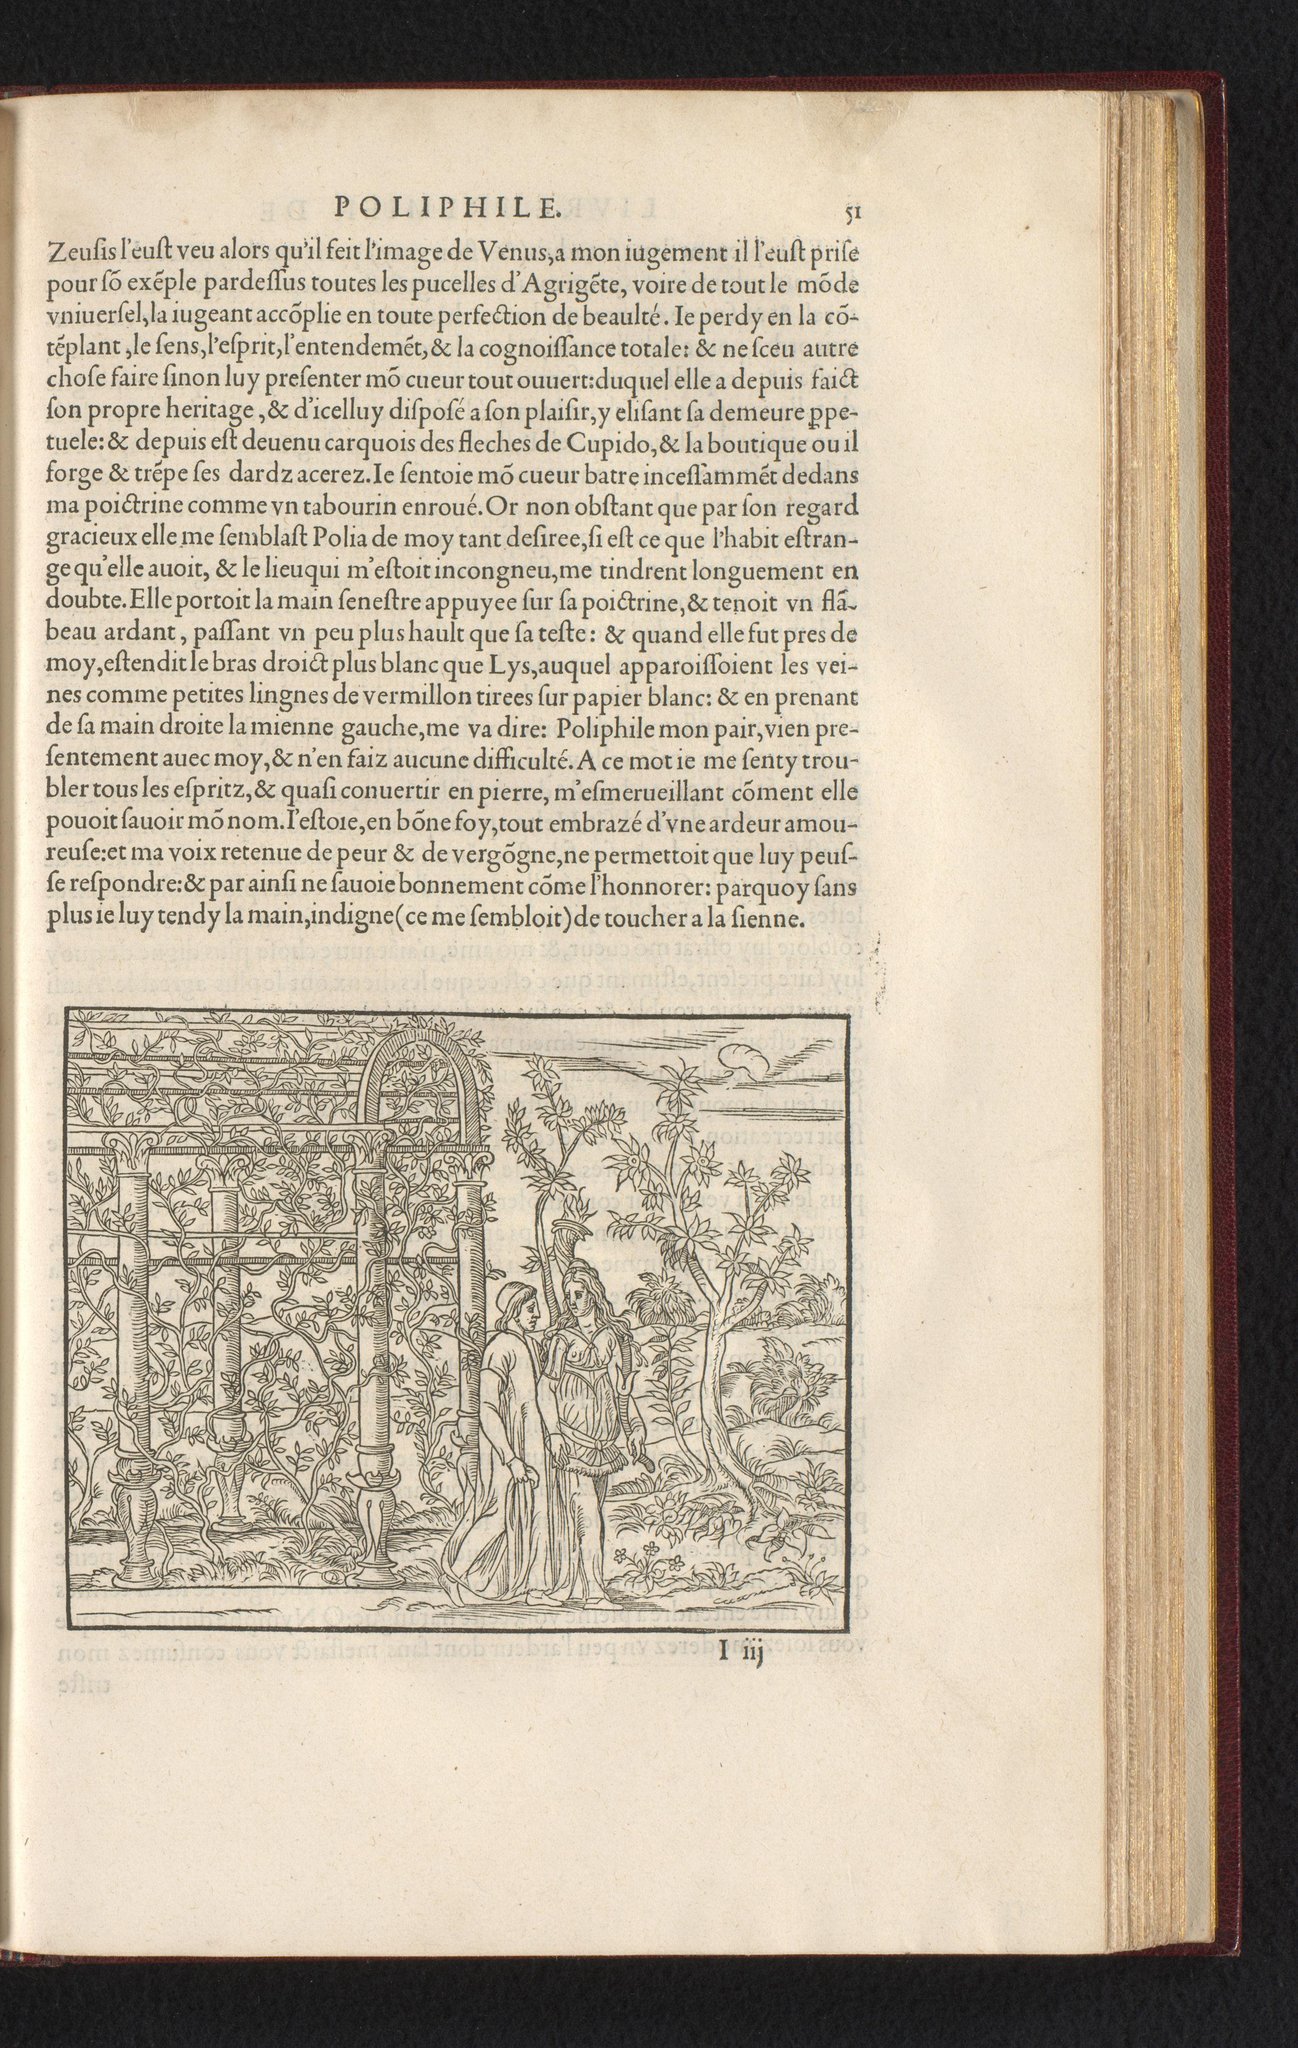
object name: page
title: Poliphilo meegevoerd door een nimf met fakkel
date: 1546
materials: paper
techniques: letterpress printing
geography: paris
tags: torch, leading someone by the hand or wrist, (scenes from) specific works of literature: colonna, hypnerotomachia poliphili, nymphs (in general); 'ninfe in commune' (ripa)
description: Prent uit: Colonna, Francesco. Hypnerotomachie ou discours du songe de Poliphile, deduisant comme amour le combat a l'occasion de Polia. Parijs: Jacques Kerver, 1546, recto fol. 51.